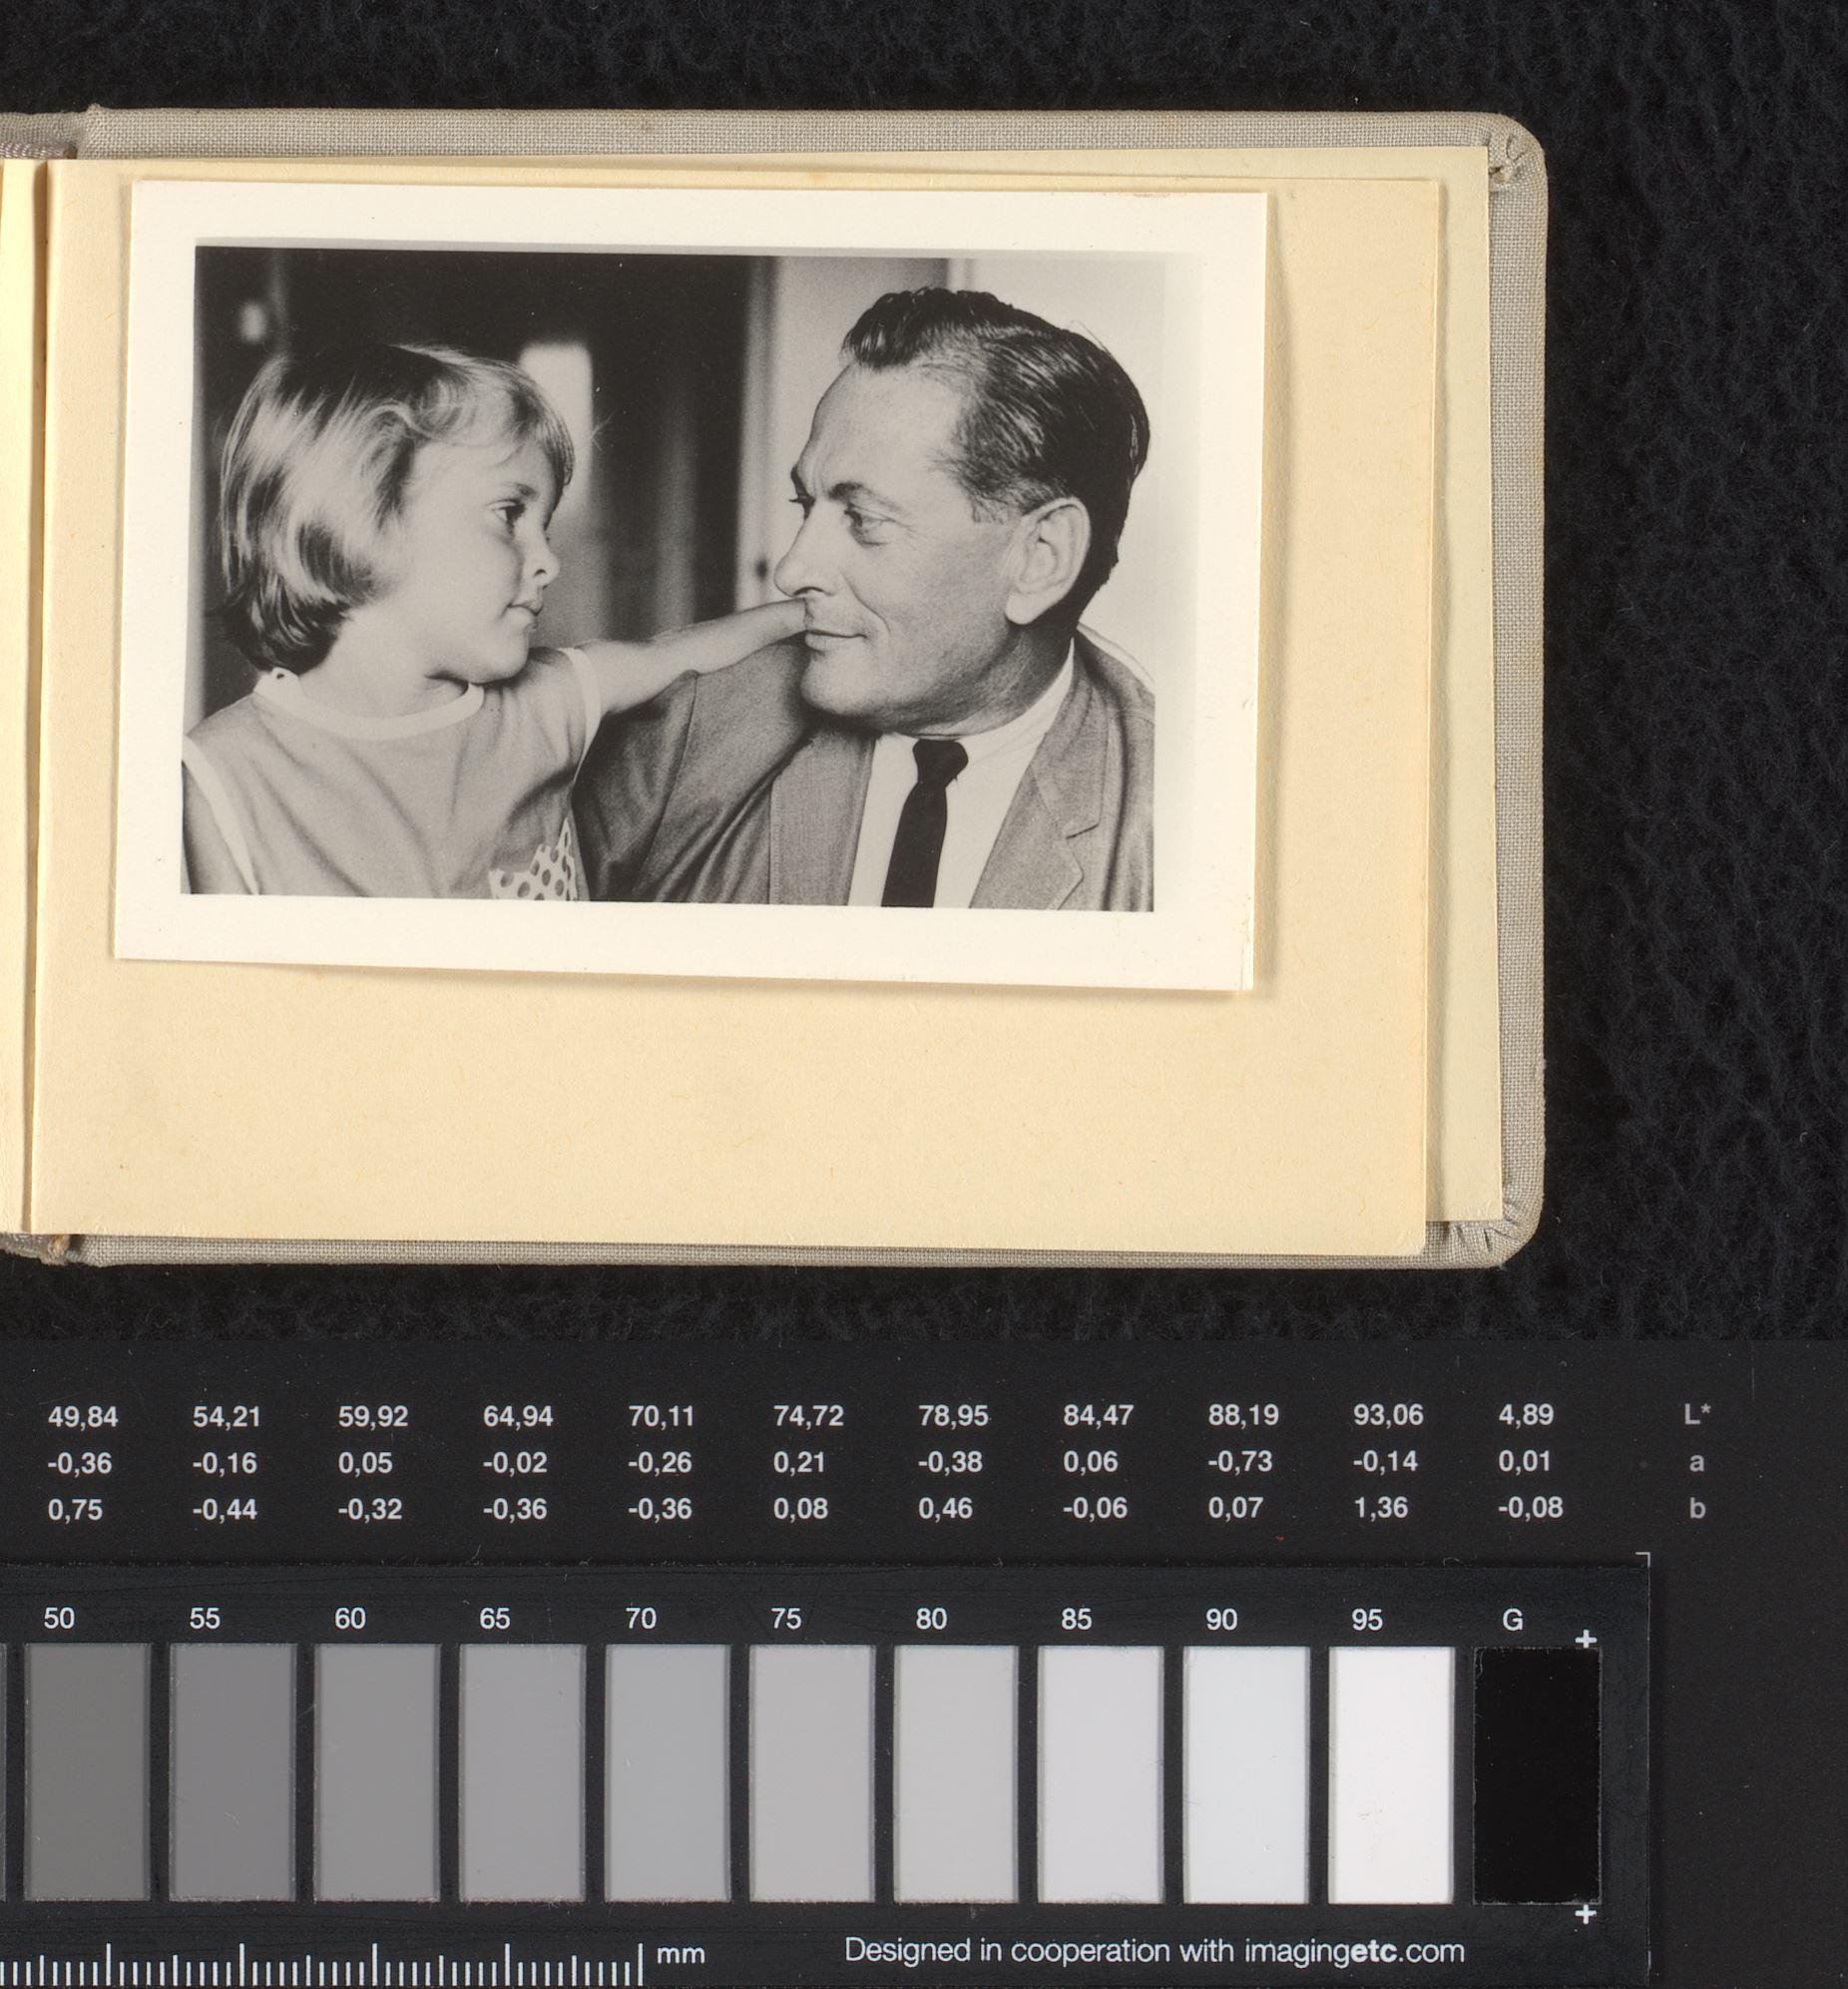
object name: photograph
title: Vader en dochter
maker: isabel wachenheimer-elon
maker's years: 1928-2010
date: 1960-1969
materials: photographic support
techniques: gelatin silver print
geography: miami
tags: gideon elon, father and daughter(s) (family group)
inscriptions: inscription: ‘Miami 196’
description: Man met meisje, waarschijnlijk Carol Elon met haar vader Gideon Elon, de echtgenoot van Isabel Wachenheimer. Miami jaren zestig. Losse foto achterin het fotoalbum met diverse foto's van de jeugd van Isabel Wachenheimer voor en tijdens de oorlog en diverse momenten van haar volwassen leven na de Tweede Wereldoorlog.